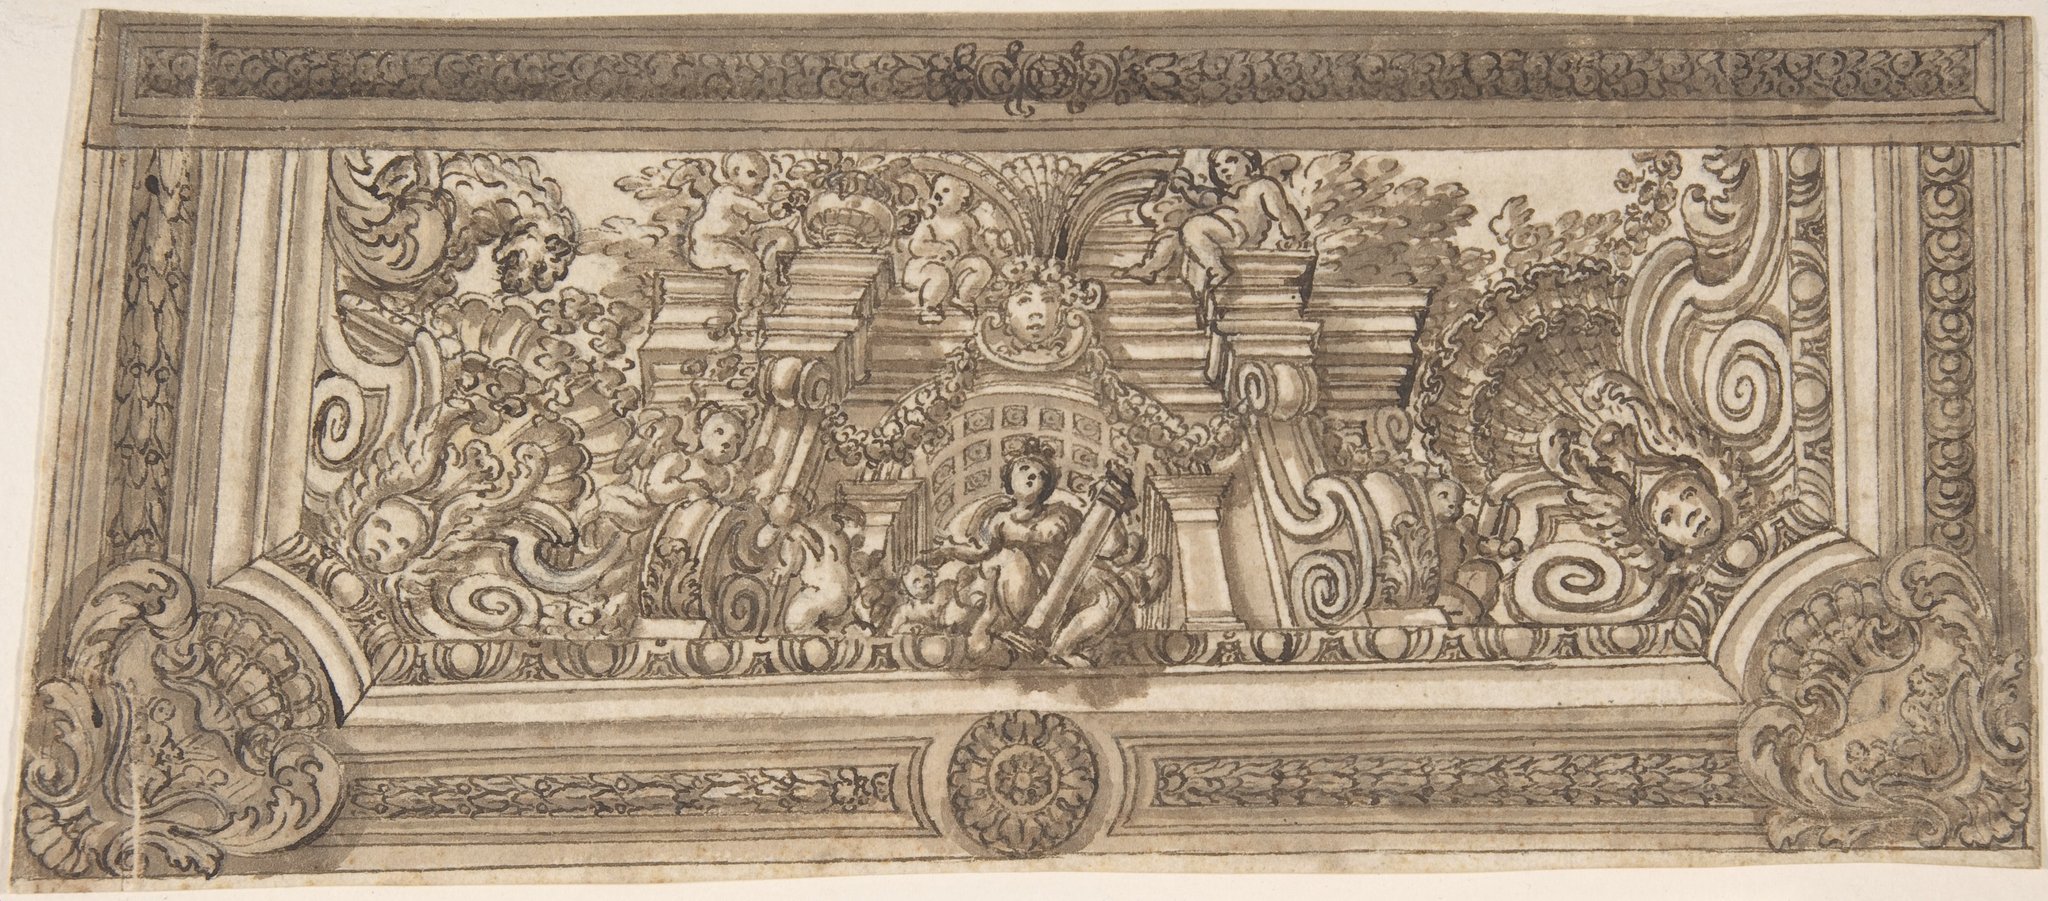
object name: drawing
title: Design for the Trompe L'Oeil Decoration of a Ceiling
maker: anonymous, italian, 18th century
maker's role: artist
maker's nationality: italian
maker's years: 1700-1800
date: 1701-1800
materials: ink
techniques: pen, wash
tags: ceilings